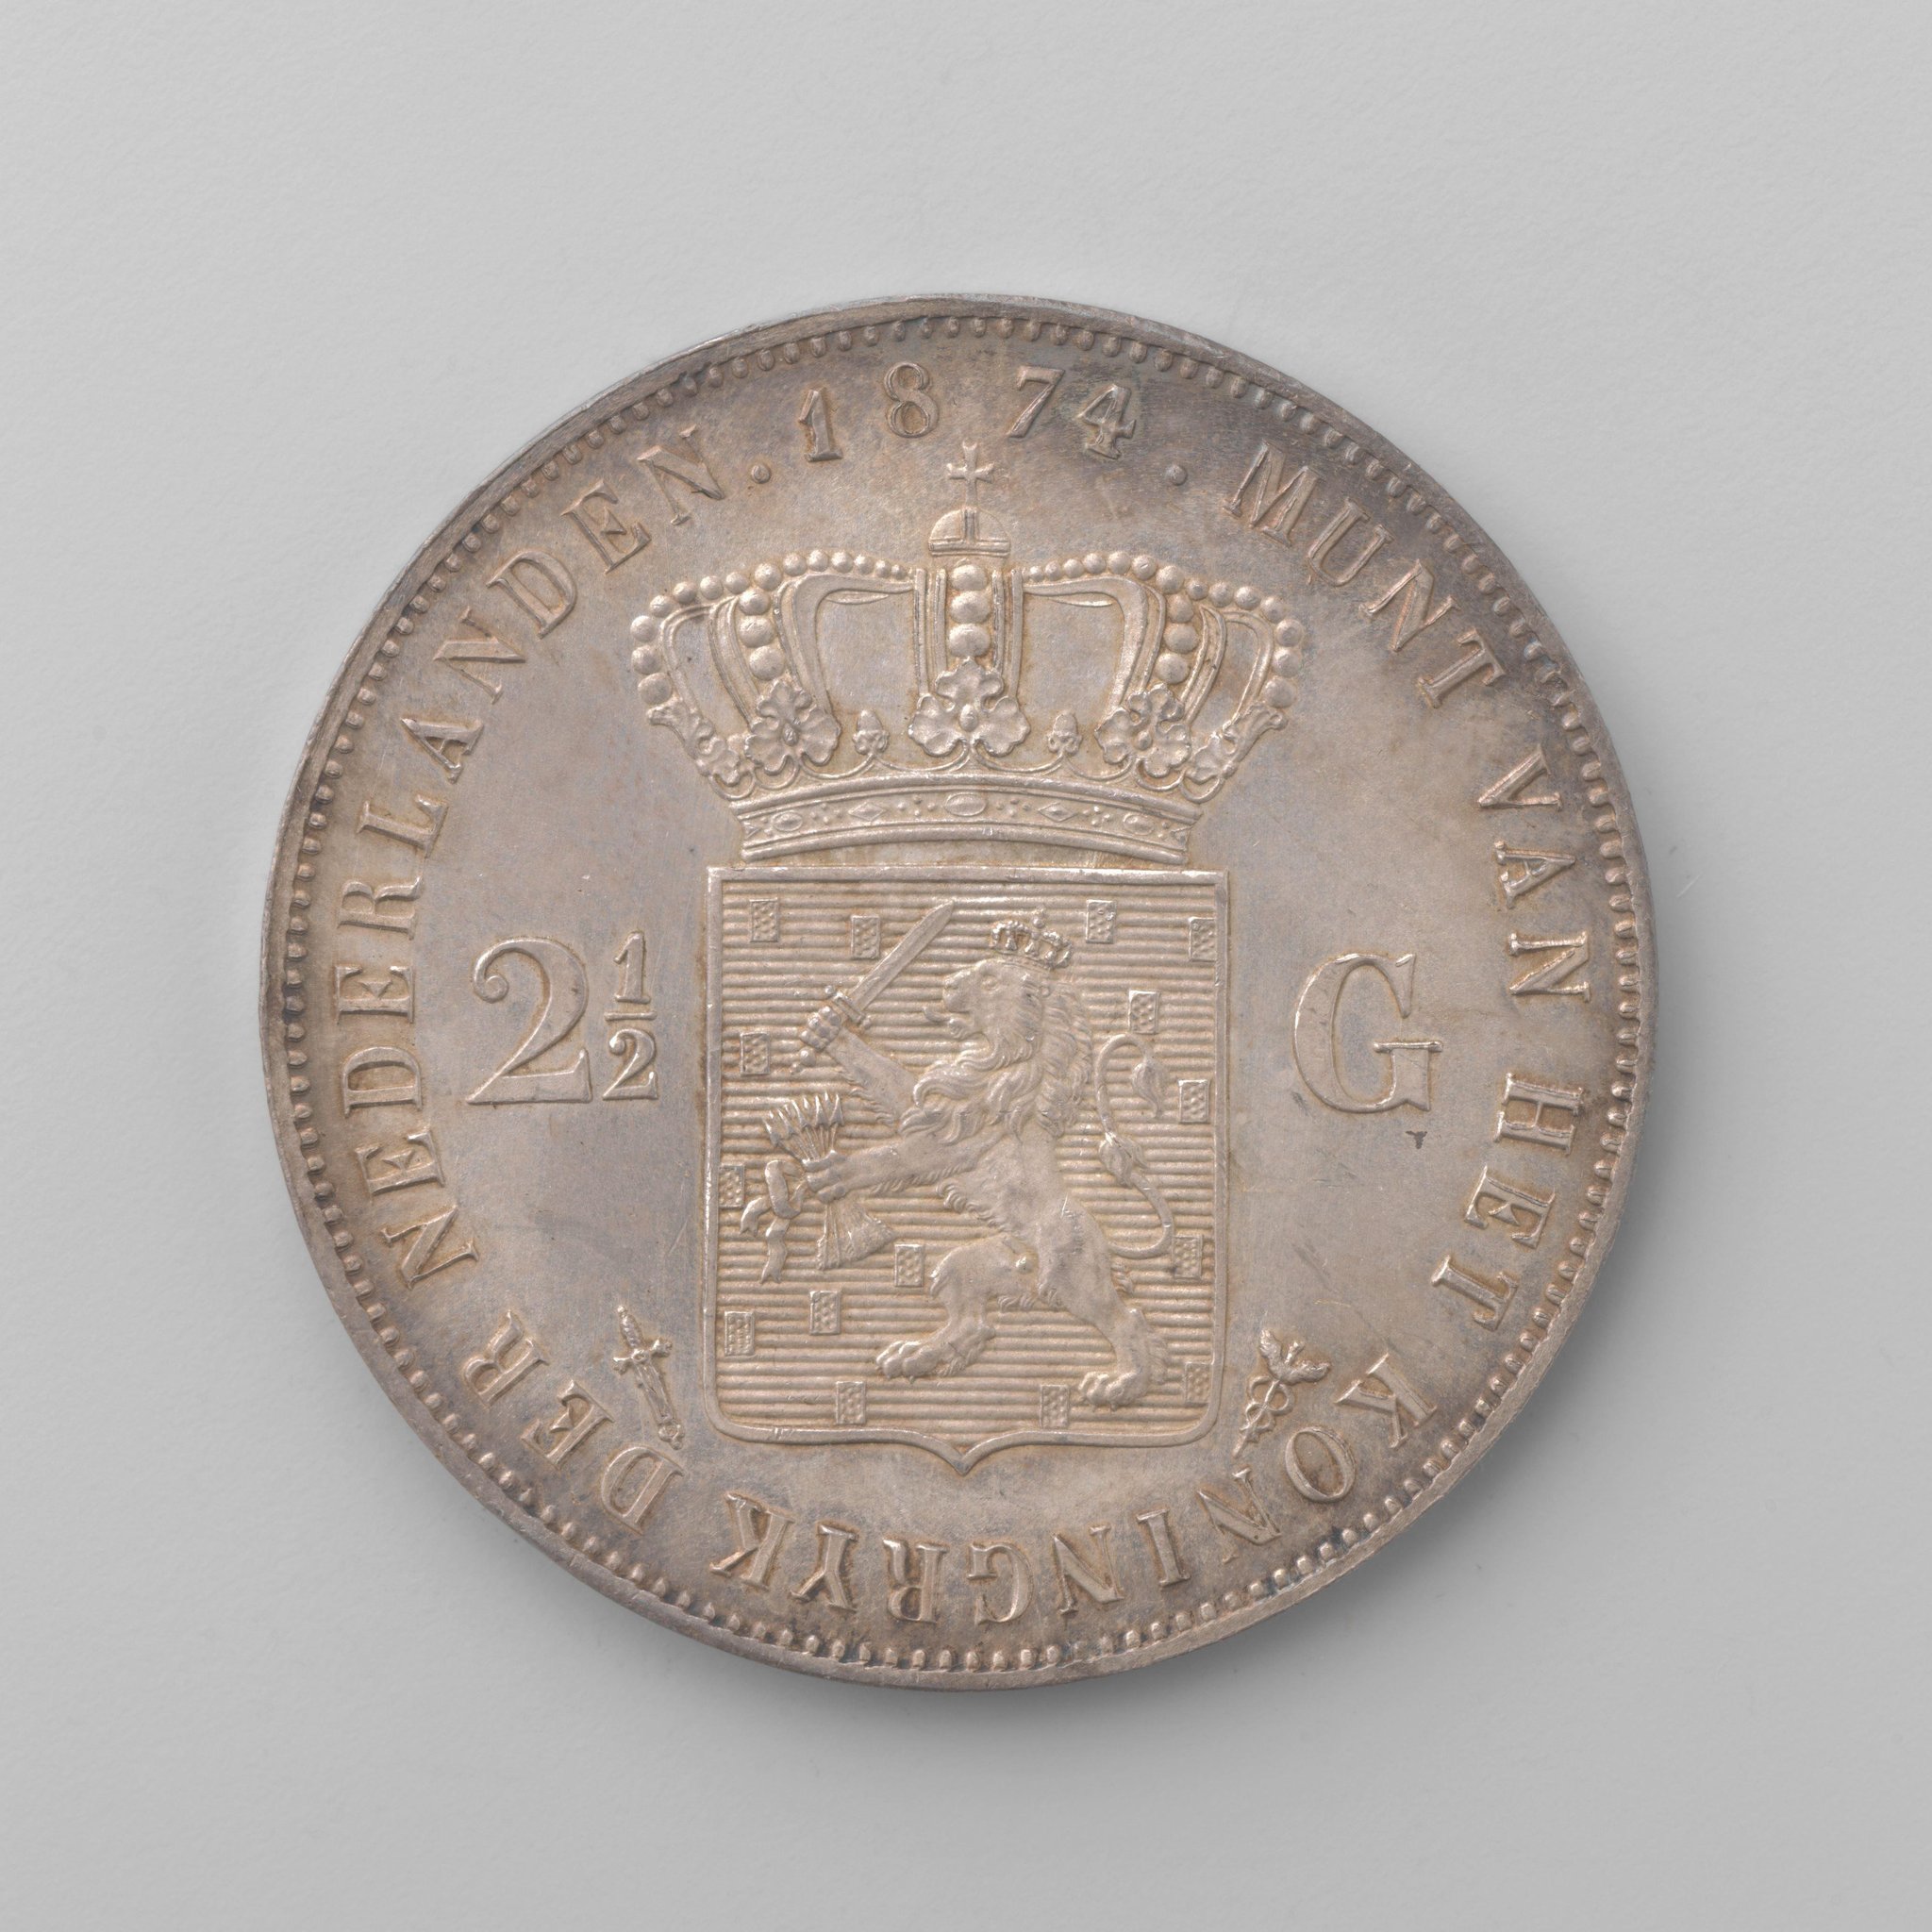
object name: coin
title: Nederland, 2½ gulden, 1874 klaverblad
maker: willem iii (koning der nederlanden)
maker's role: koning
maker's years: 1817-1890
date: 1874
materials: silver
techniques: striking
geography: utrecht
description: Zilveren munt. Voorzijde: borstbeeld naar rechts. Keerzijde: tussen waarde-aanduiding 2½ G gekroond rijkswapenschild. Aan onderkant links van het wapenschild muntmeesterteken: zwaard met klaverbladvormig uiteinde. Jaartal boven kroon. Randschrift.